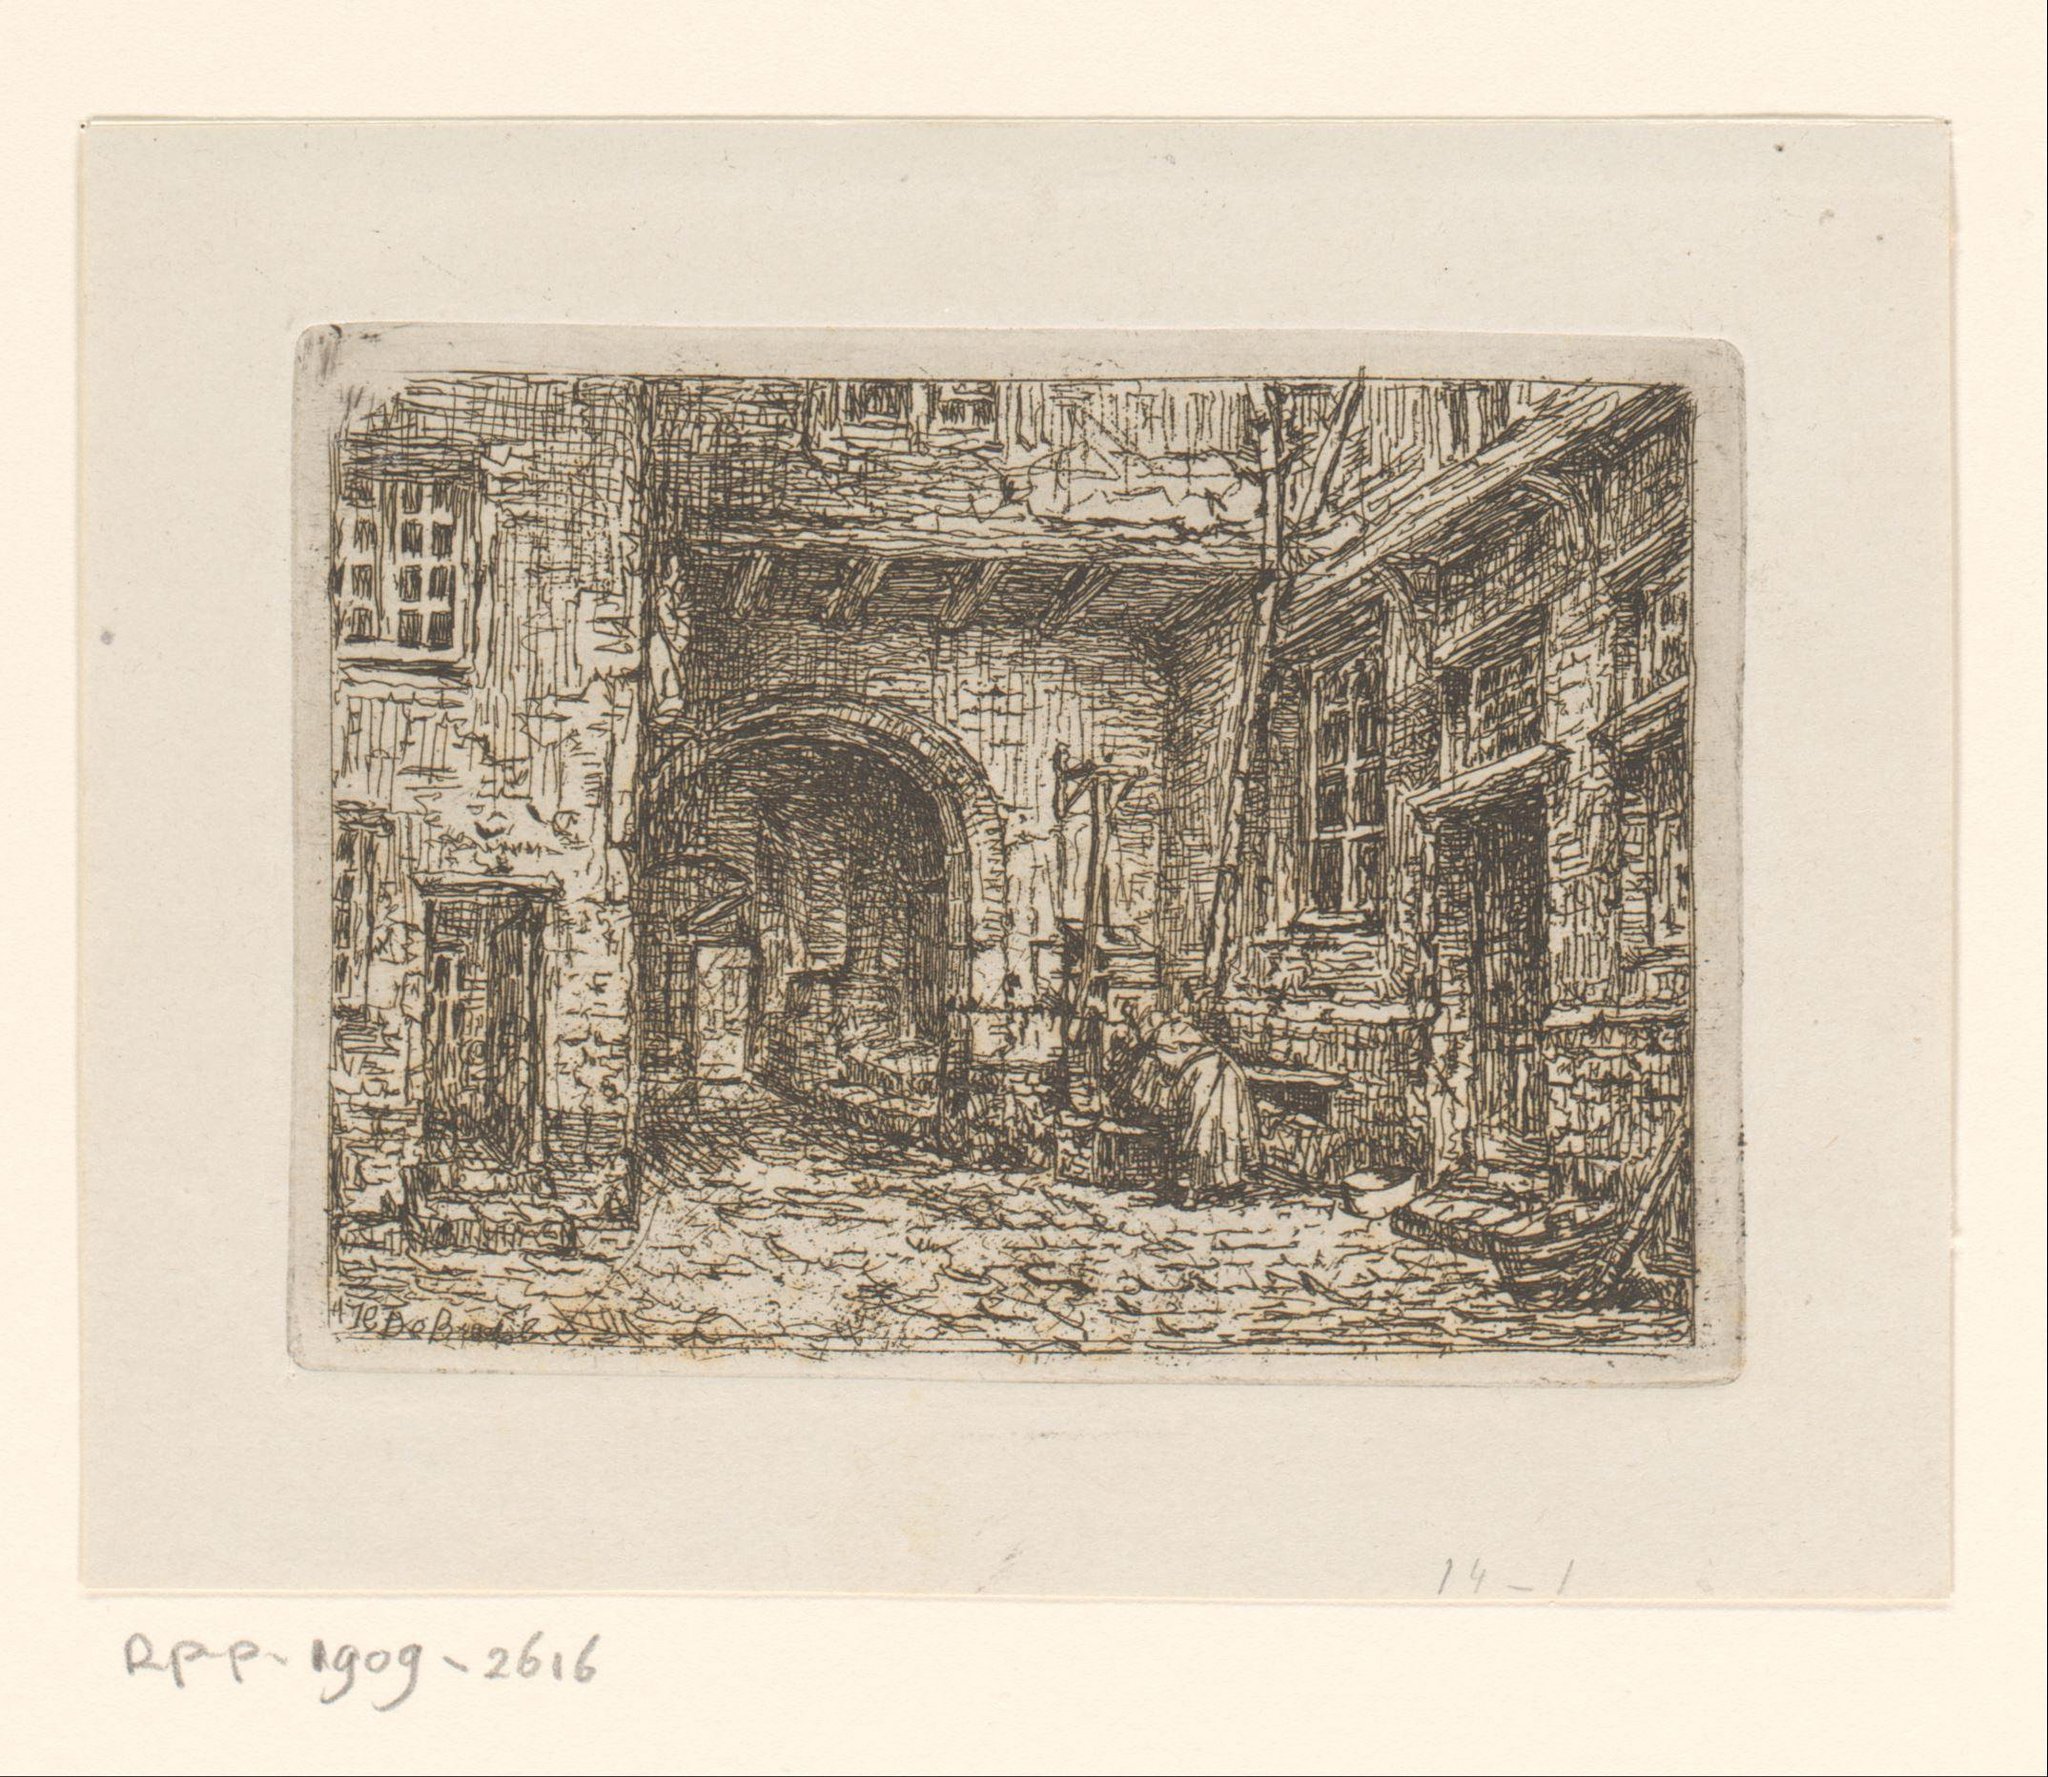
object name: print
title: Vrouw bij een pomp op straat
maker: henri de braekeleer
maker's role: draughtsman, print maker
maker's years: 1840-1888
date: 1850-1879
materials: paper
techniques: etching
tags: street, utilitarian, public pump or water fountain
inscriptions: collector's mark: Lugt 1485, collector's mark: Lugt 2228